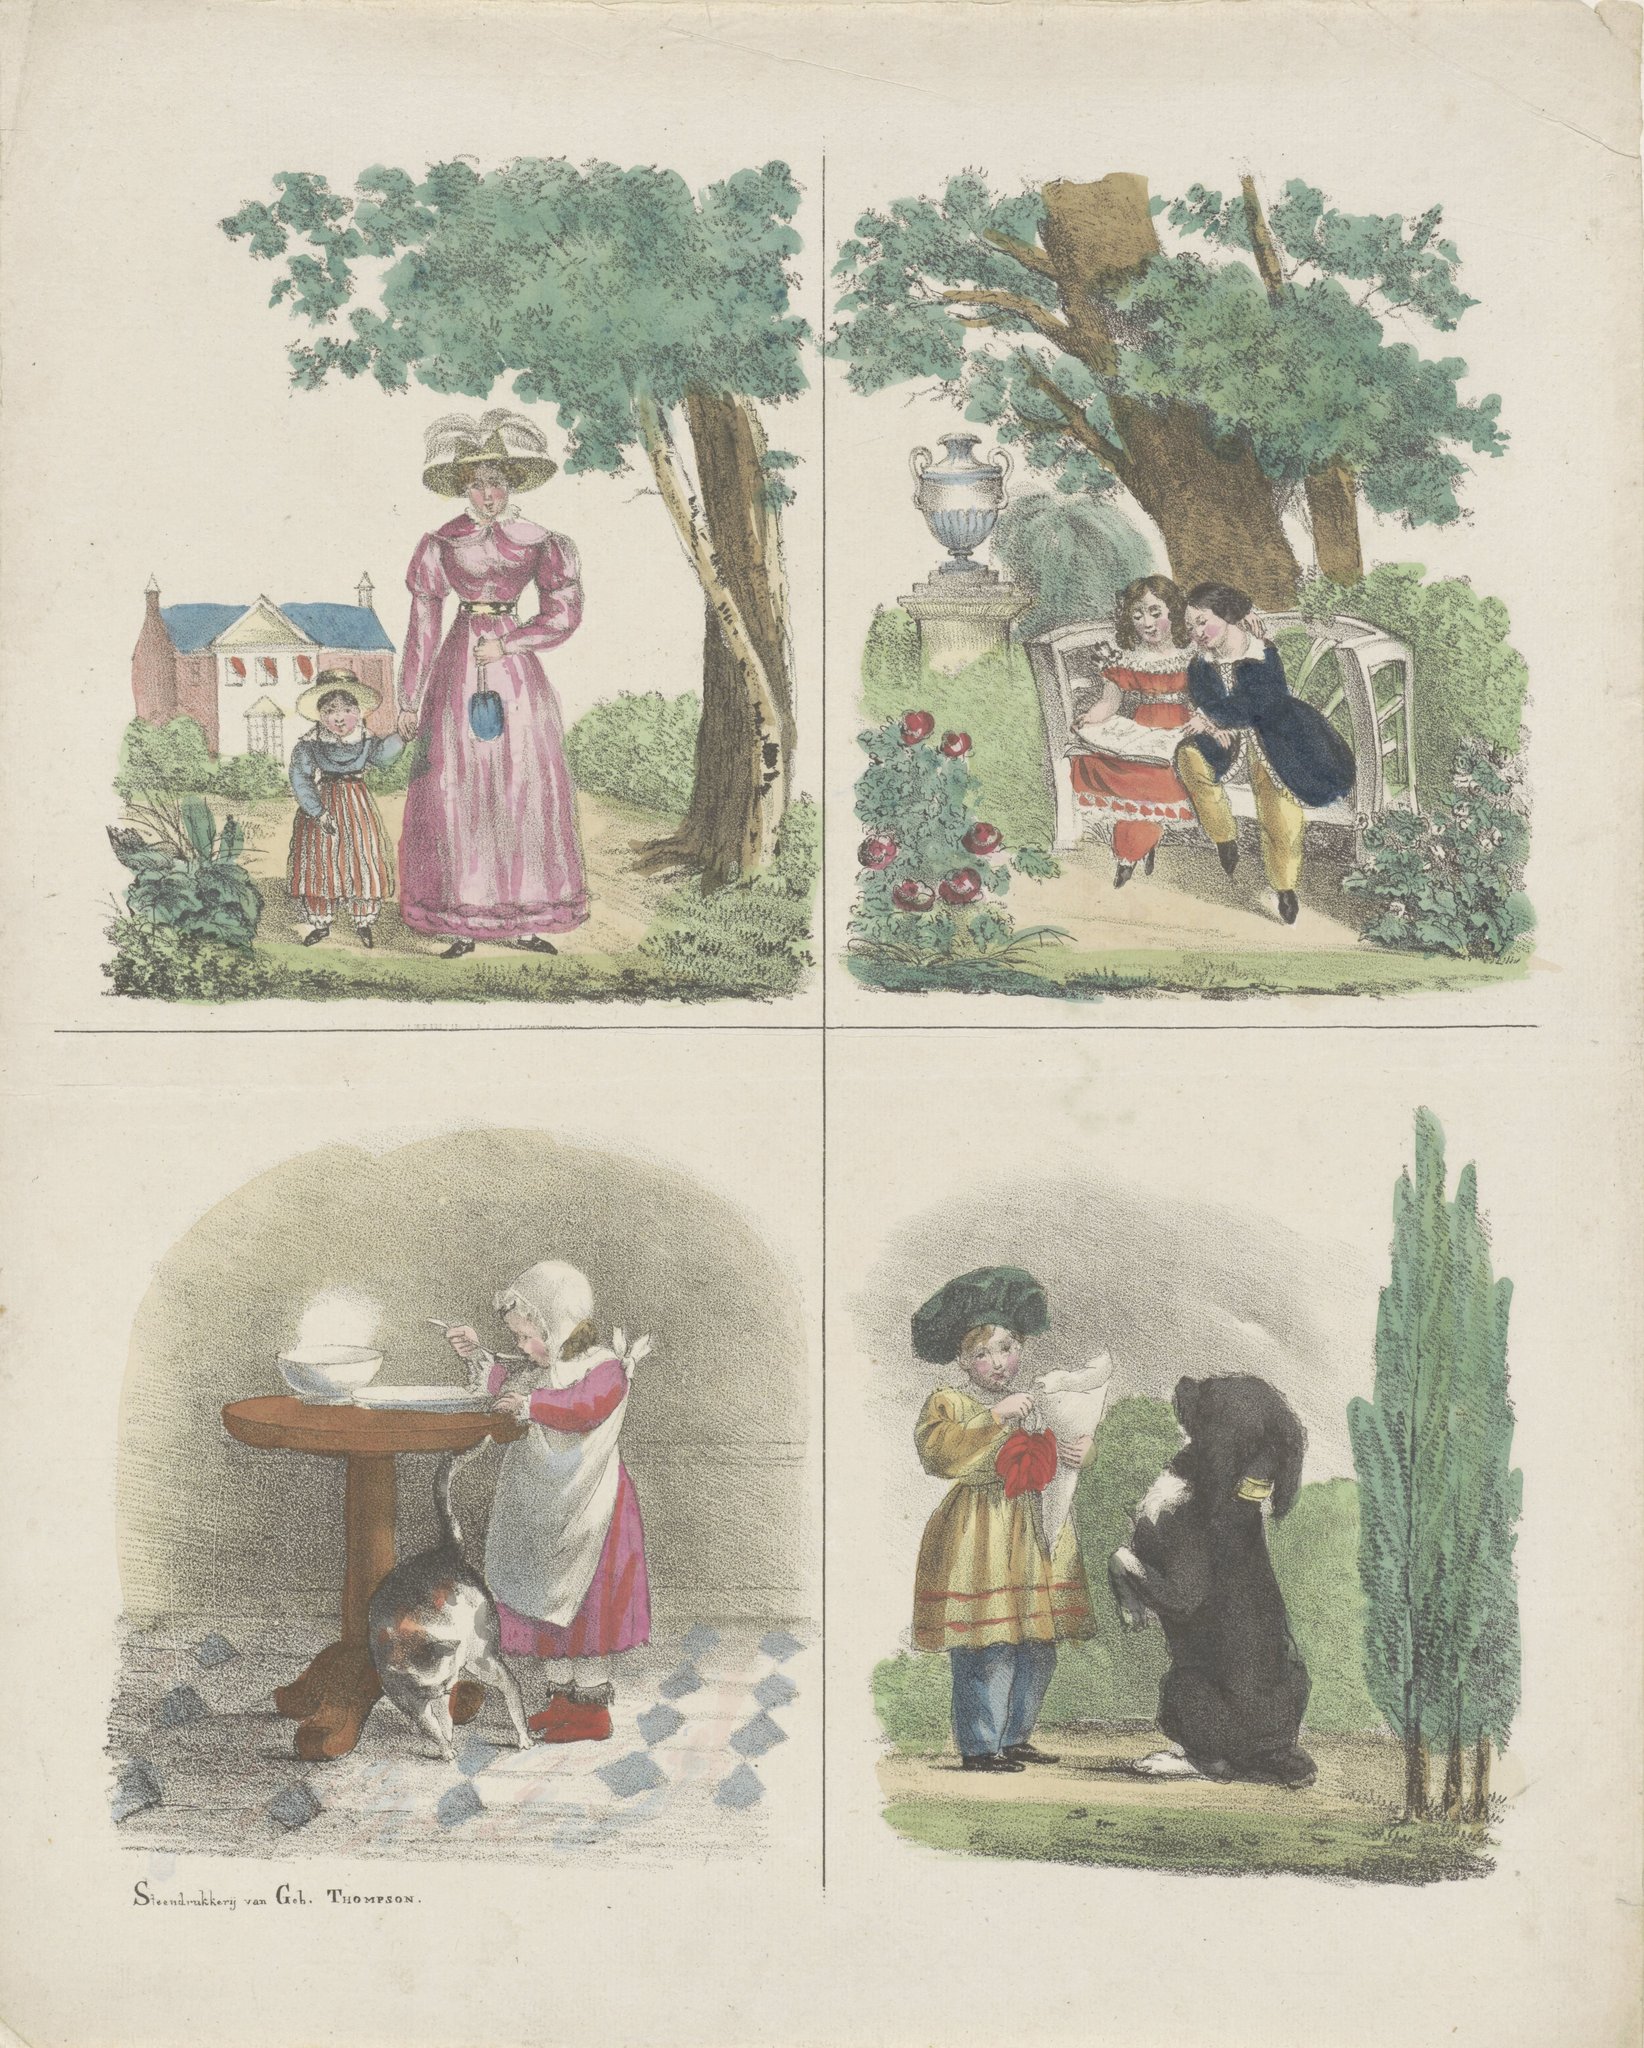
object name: print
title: Kindertaferelen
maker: Anonymous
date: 1825-1829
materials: paper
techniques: hand coloring, lithograph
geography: netherlands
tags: walking, hiking (recreation), reading, child, child playing with animals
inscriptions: collector's mark: Lugt 2760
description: Blad met 4 voorstellingen over het kinderleven, waaronder een moeder en dochter wandelend, twee kinderen lezend op een bankje, een meisje met een kat en een jongetje met een hond.